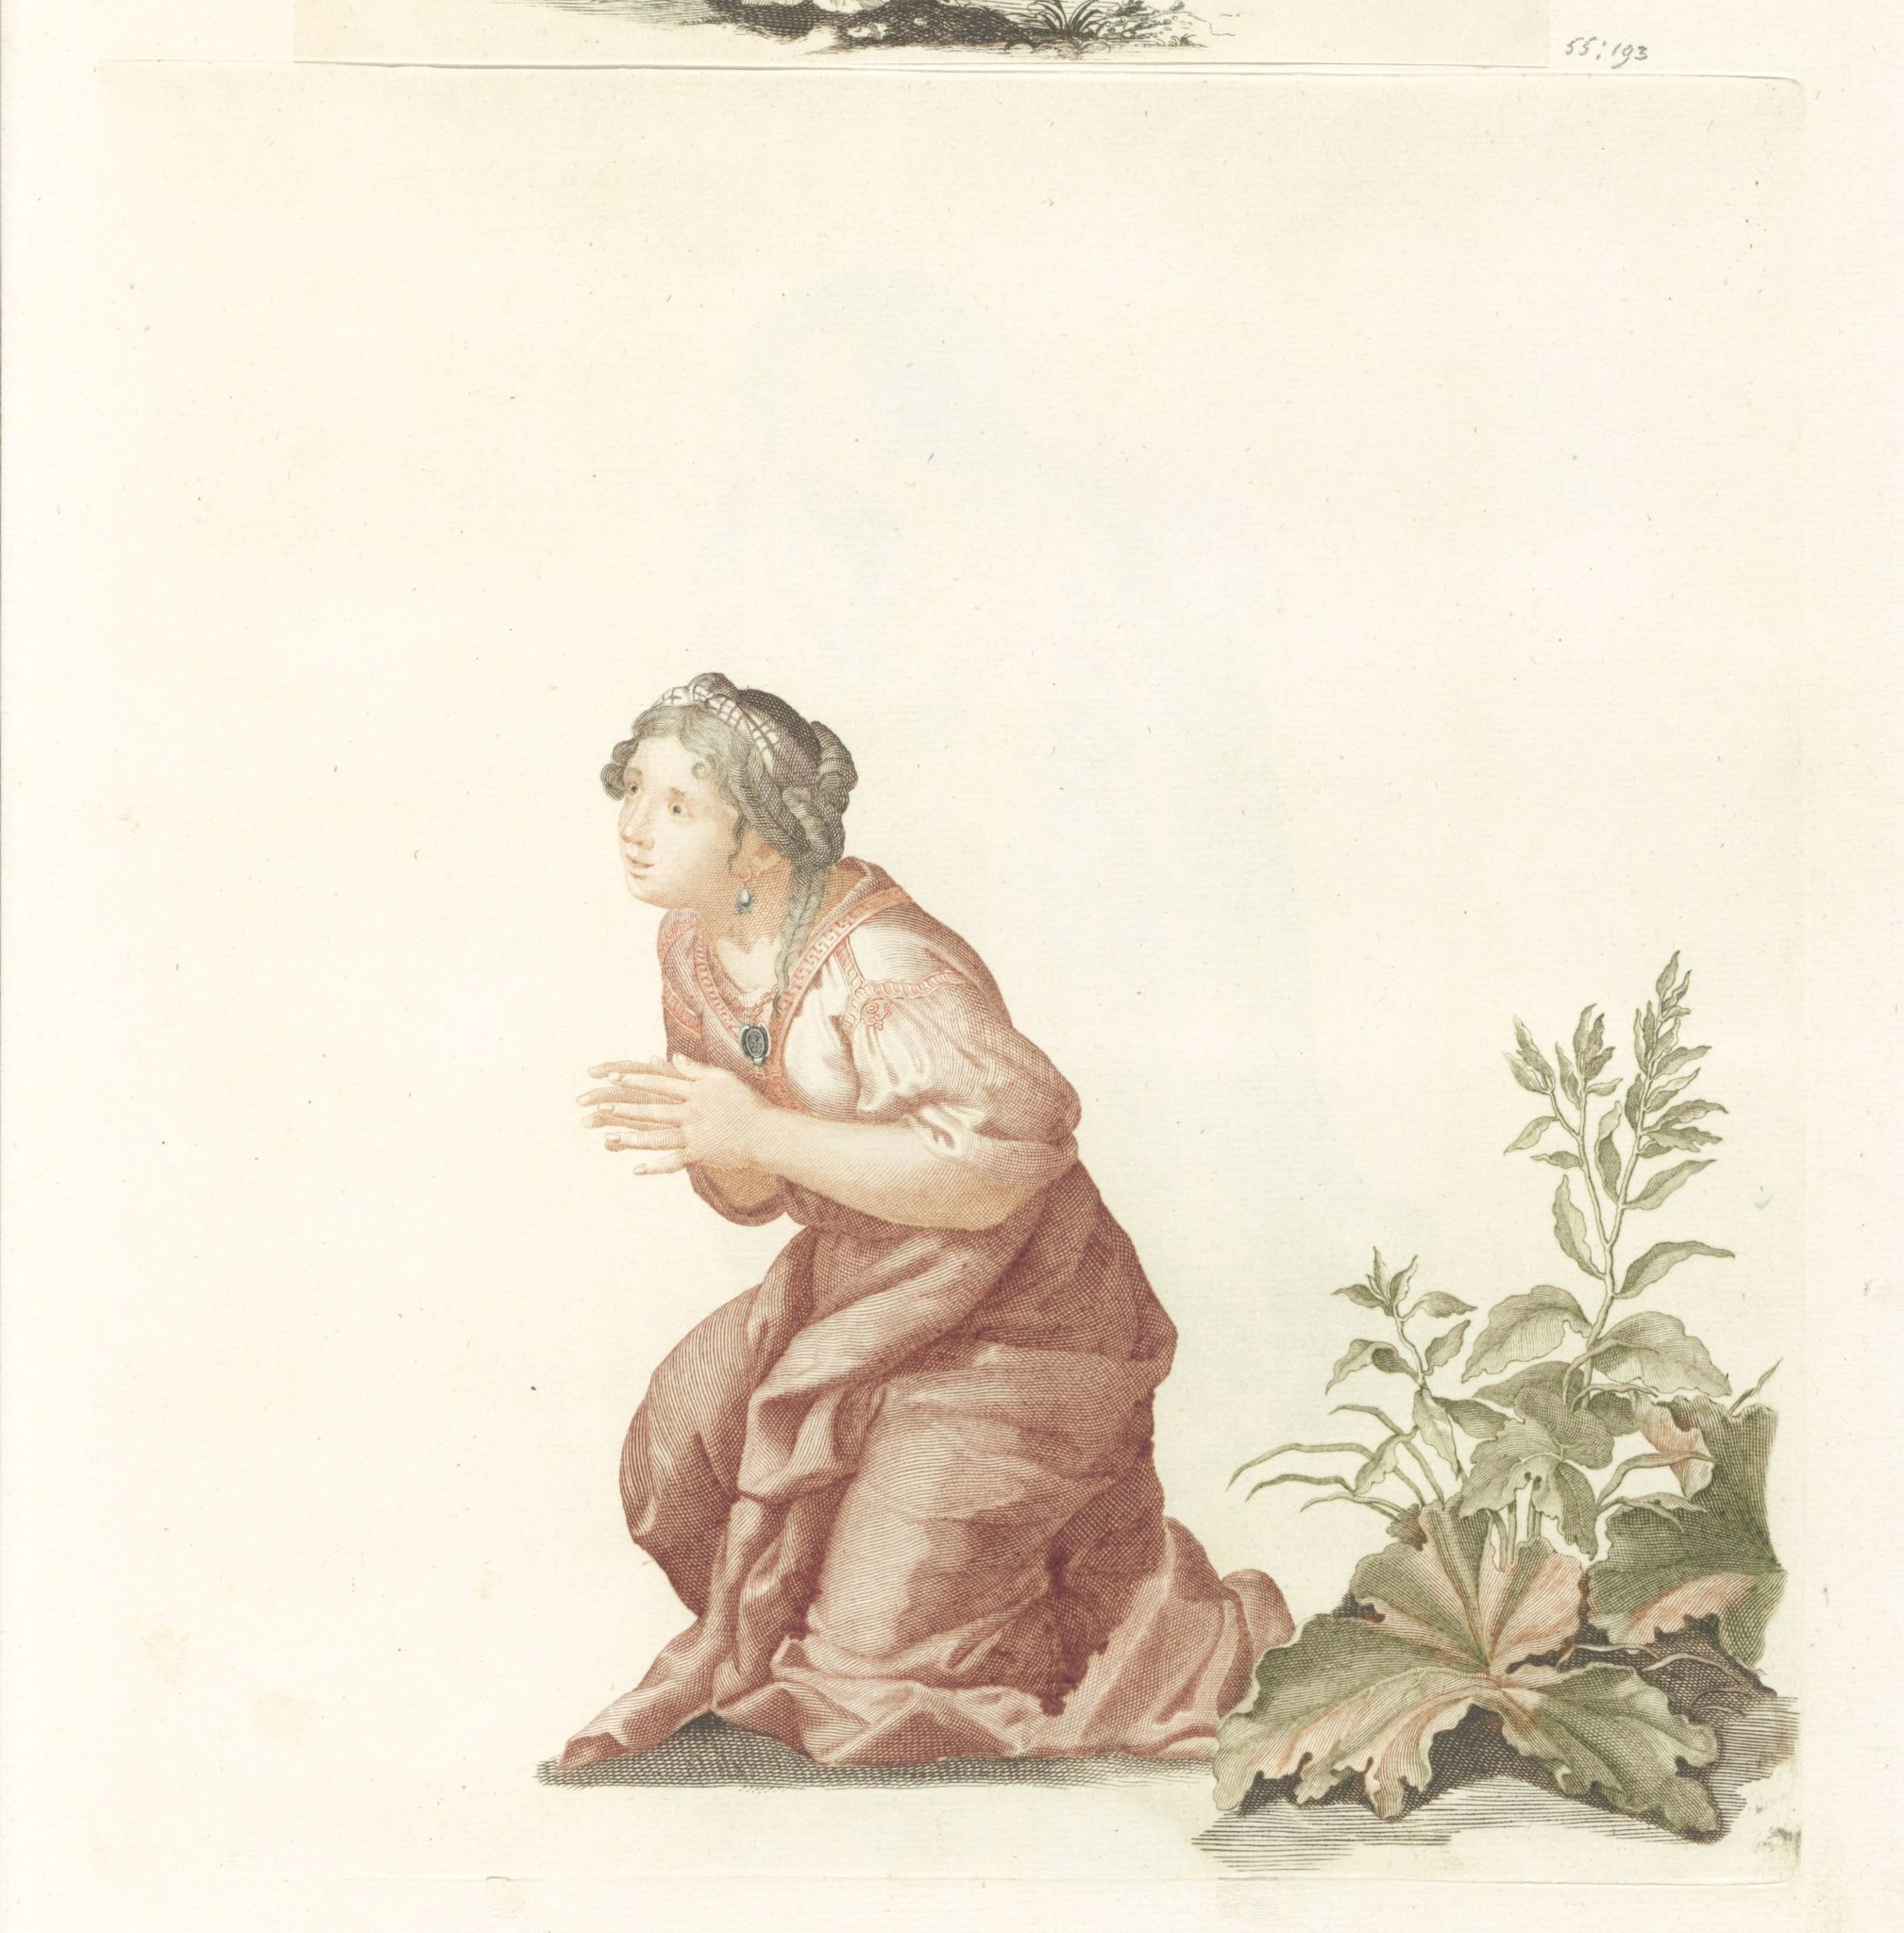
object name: album leaf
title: Knielende vrouw naast plant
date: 1688-1698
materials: paper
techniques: printing, engraving, lithography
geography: netherlands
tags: plants (in general), kneeling figure - aa - female human figure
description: Een geknielde vrouw zit naast een plant. Deze prent maakt deel uit van een album.